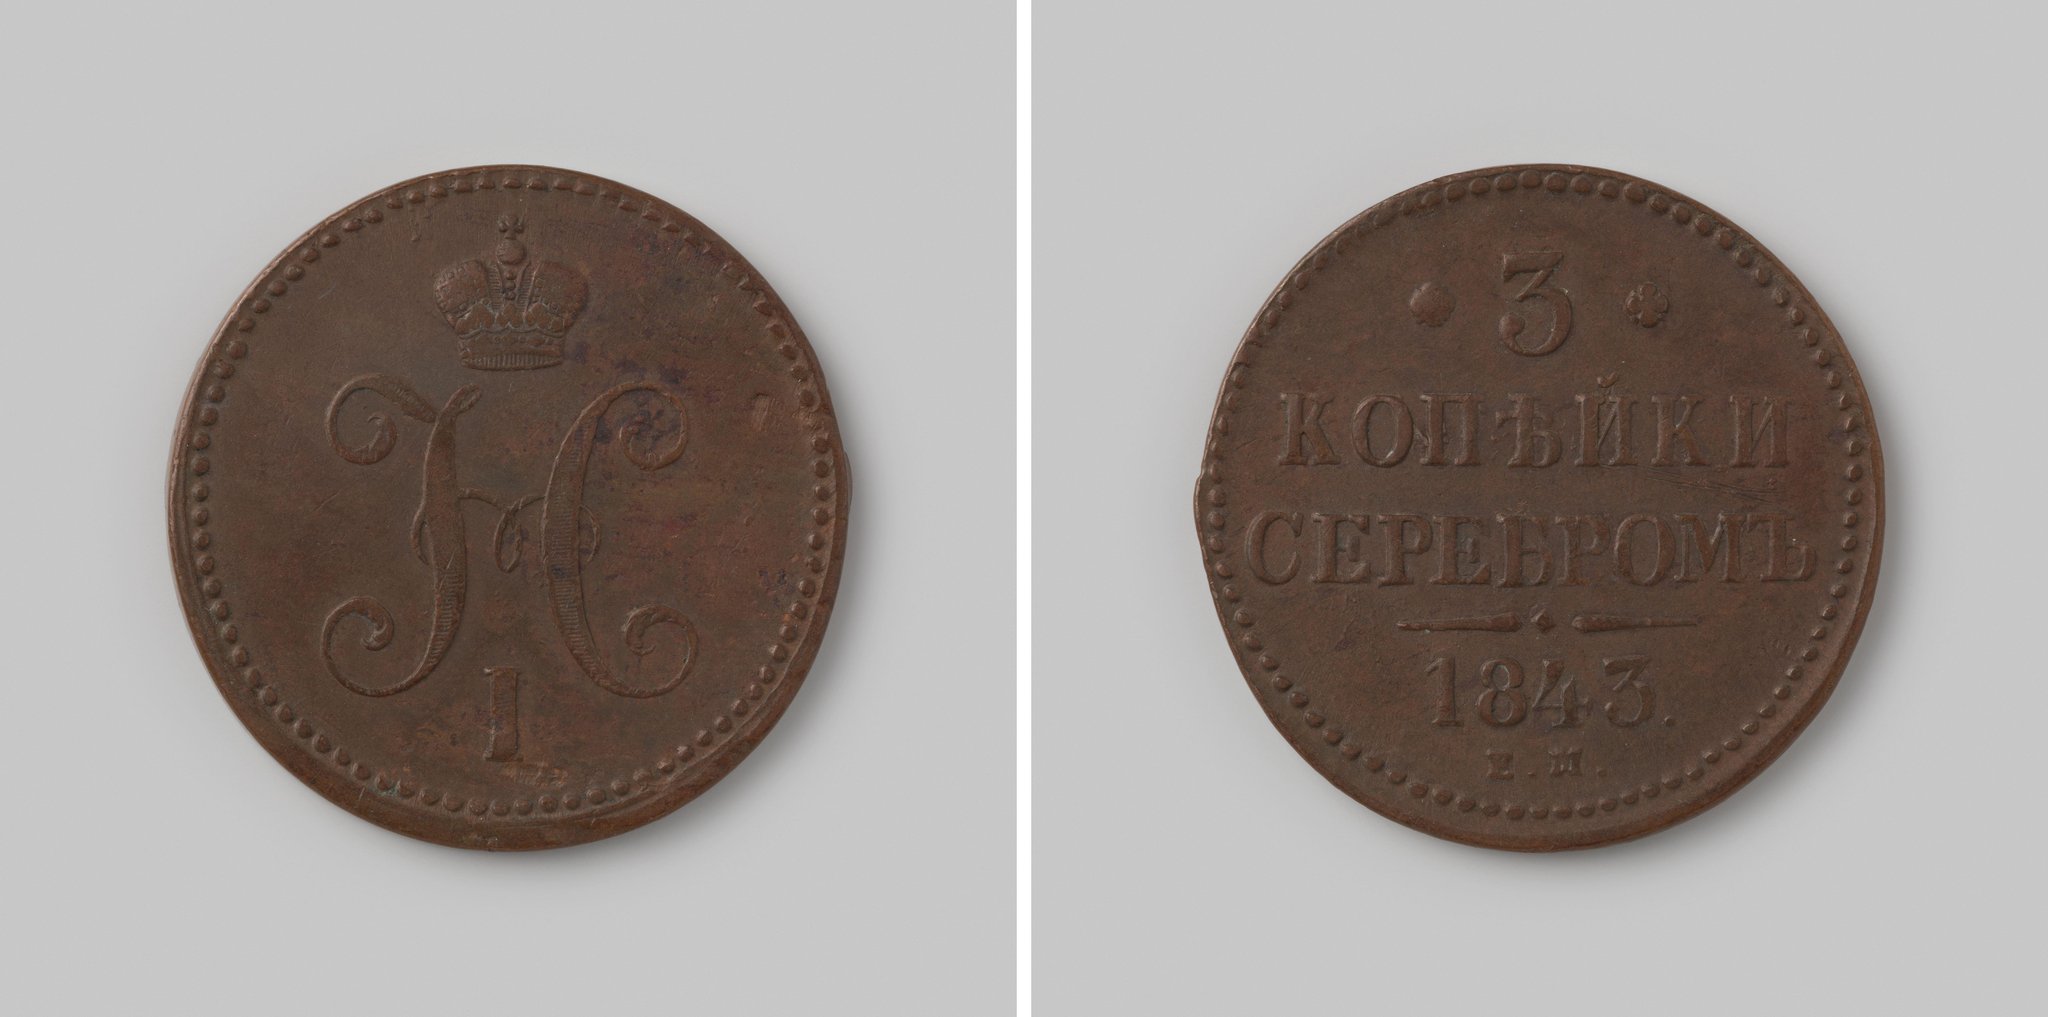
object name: coin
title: 3 kopeken uit Rusland van tsaar Nikolai I, 1843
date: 1843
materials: copper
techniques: striking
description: Koperen munt. Voorzijde: gekroond monogram van Nicolai I in het cyrillisch. Keerzijde: in drie regels waarde-aanduiding. Daaronder jaartal, waaronder in het Cyrillisch de letters E en M [=Ekaterinenburg]. Gladde rand.